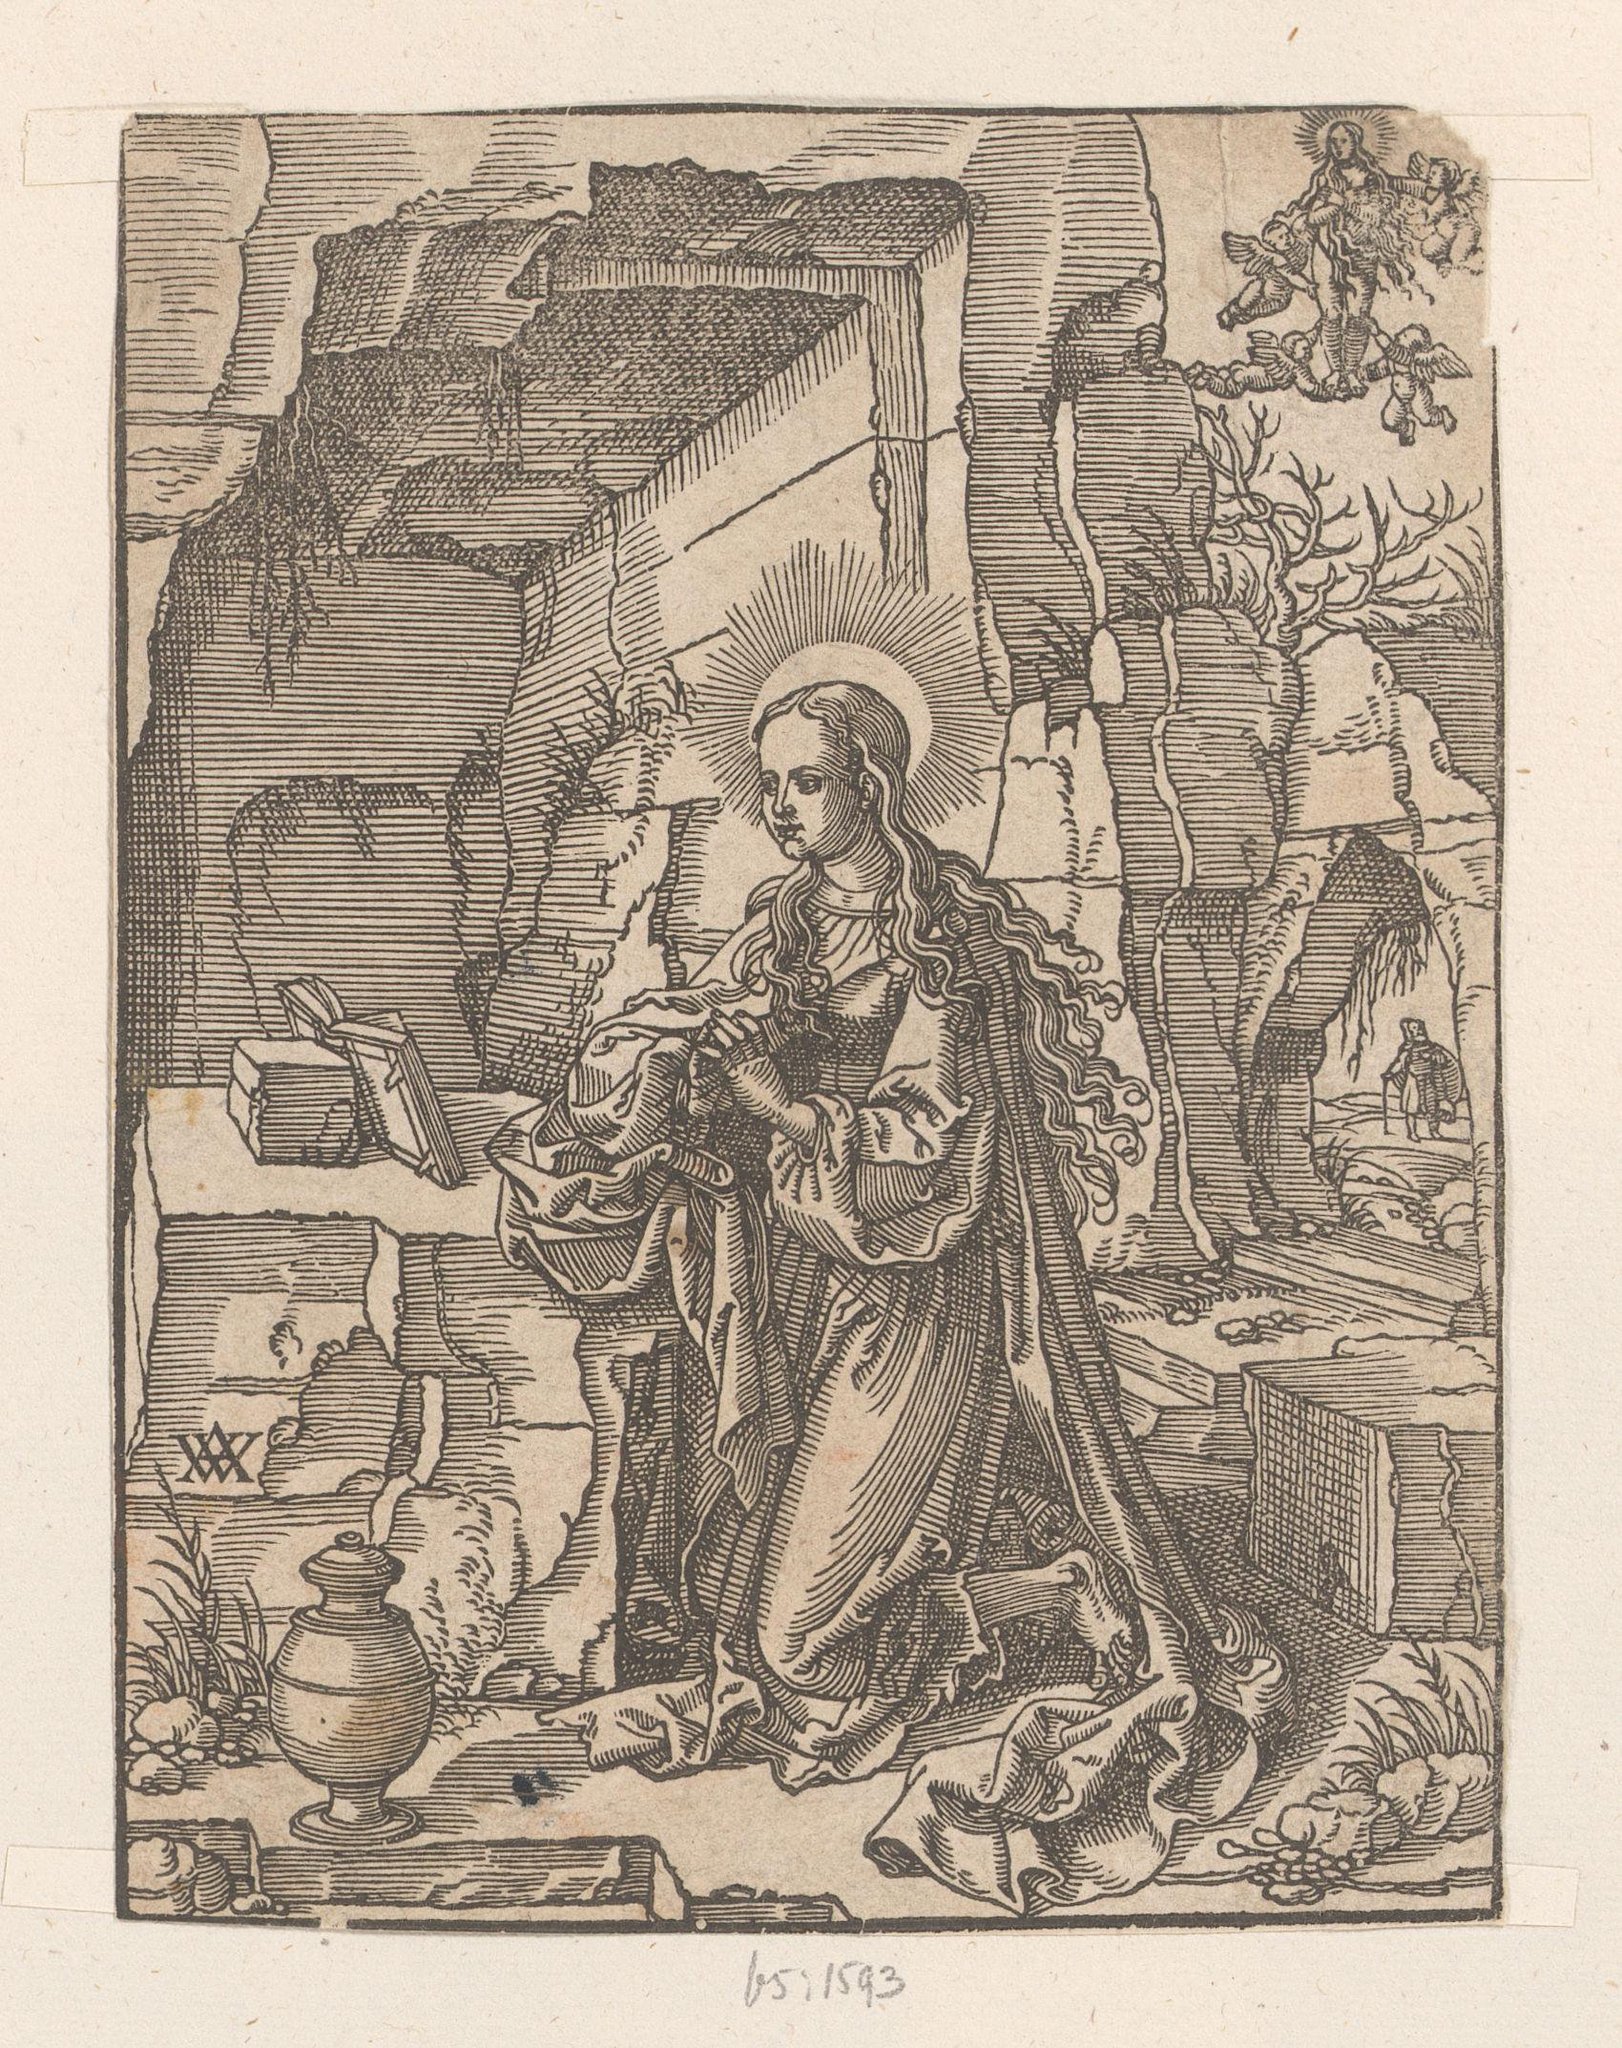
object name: album leaf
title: Boetvaardige Maria Magdalena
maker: anton von woensam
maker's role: print maker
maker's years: 1500-1541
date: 1500-1541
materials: paper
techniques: woodcut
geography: germany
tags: the penitent harlot mary magdalene; possible attributes: book (or scroll), crown, crown of thorns, crucifix, jar of ointment, mirror, musical instrument, palm-branch, rosary, scourge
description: De boetvaardige Maria Magdalena knielt neer in een grot bij een geopend gebedenboek. Links op de voorgrond haar zalfpot. Prent maakt deel uit van een album.